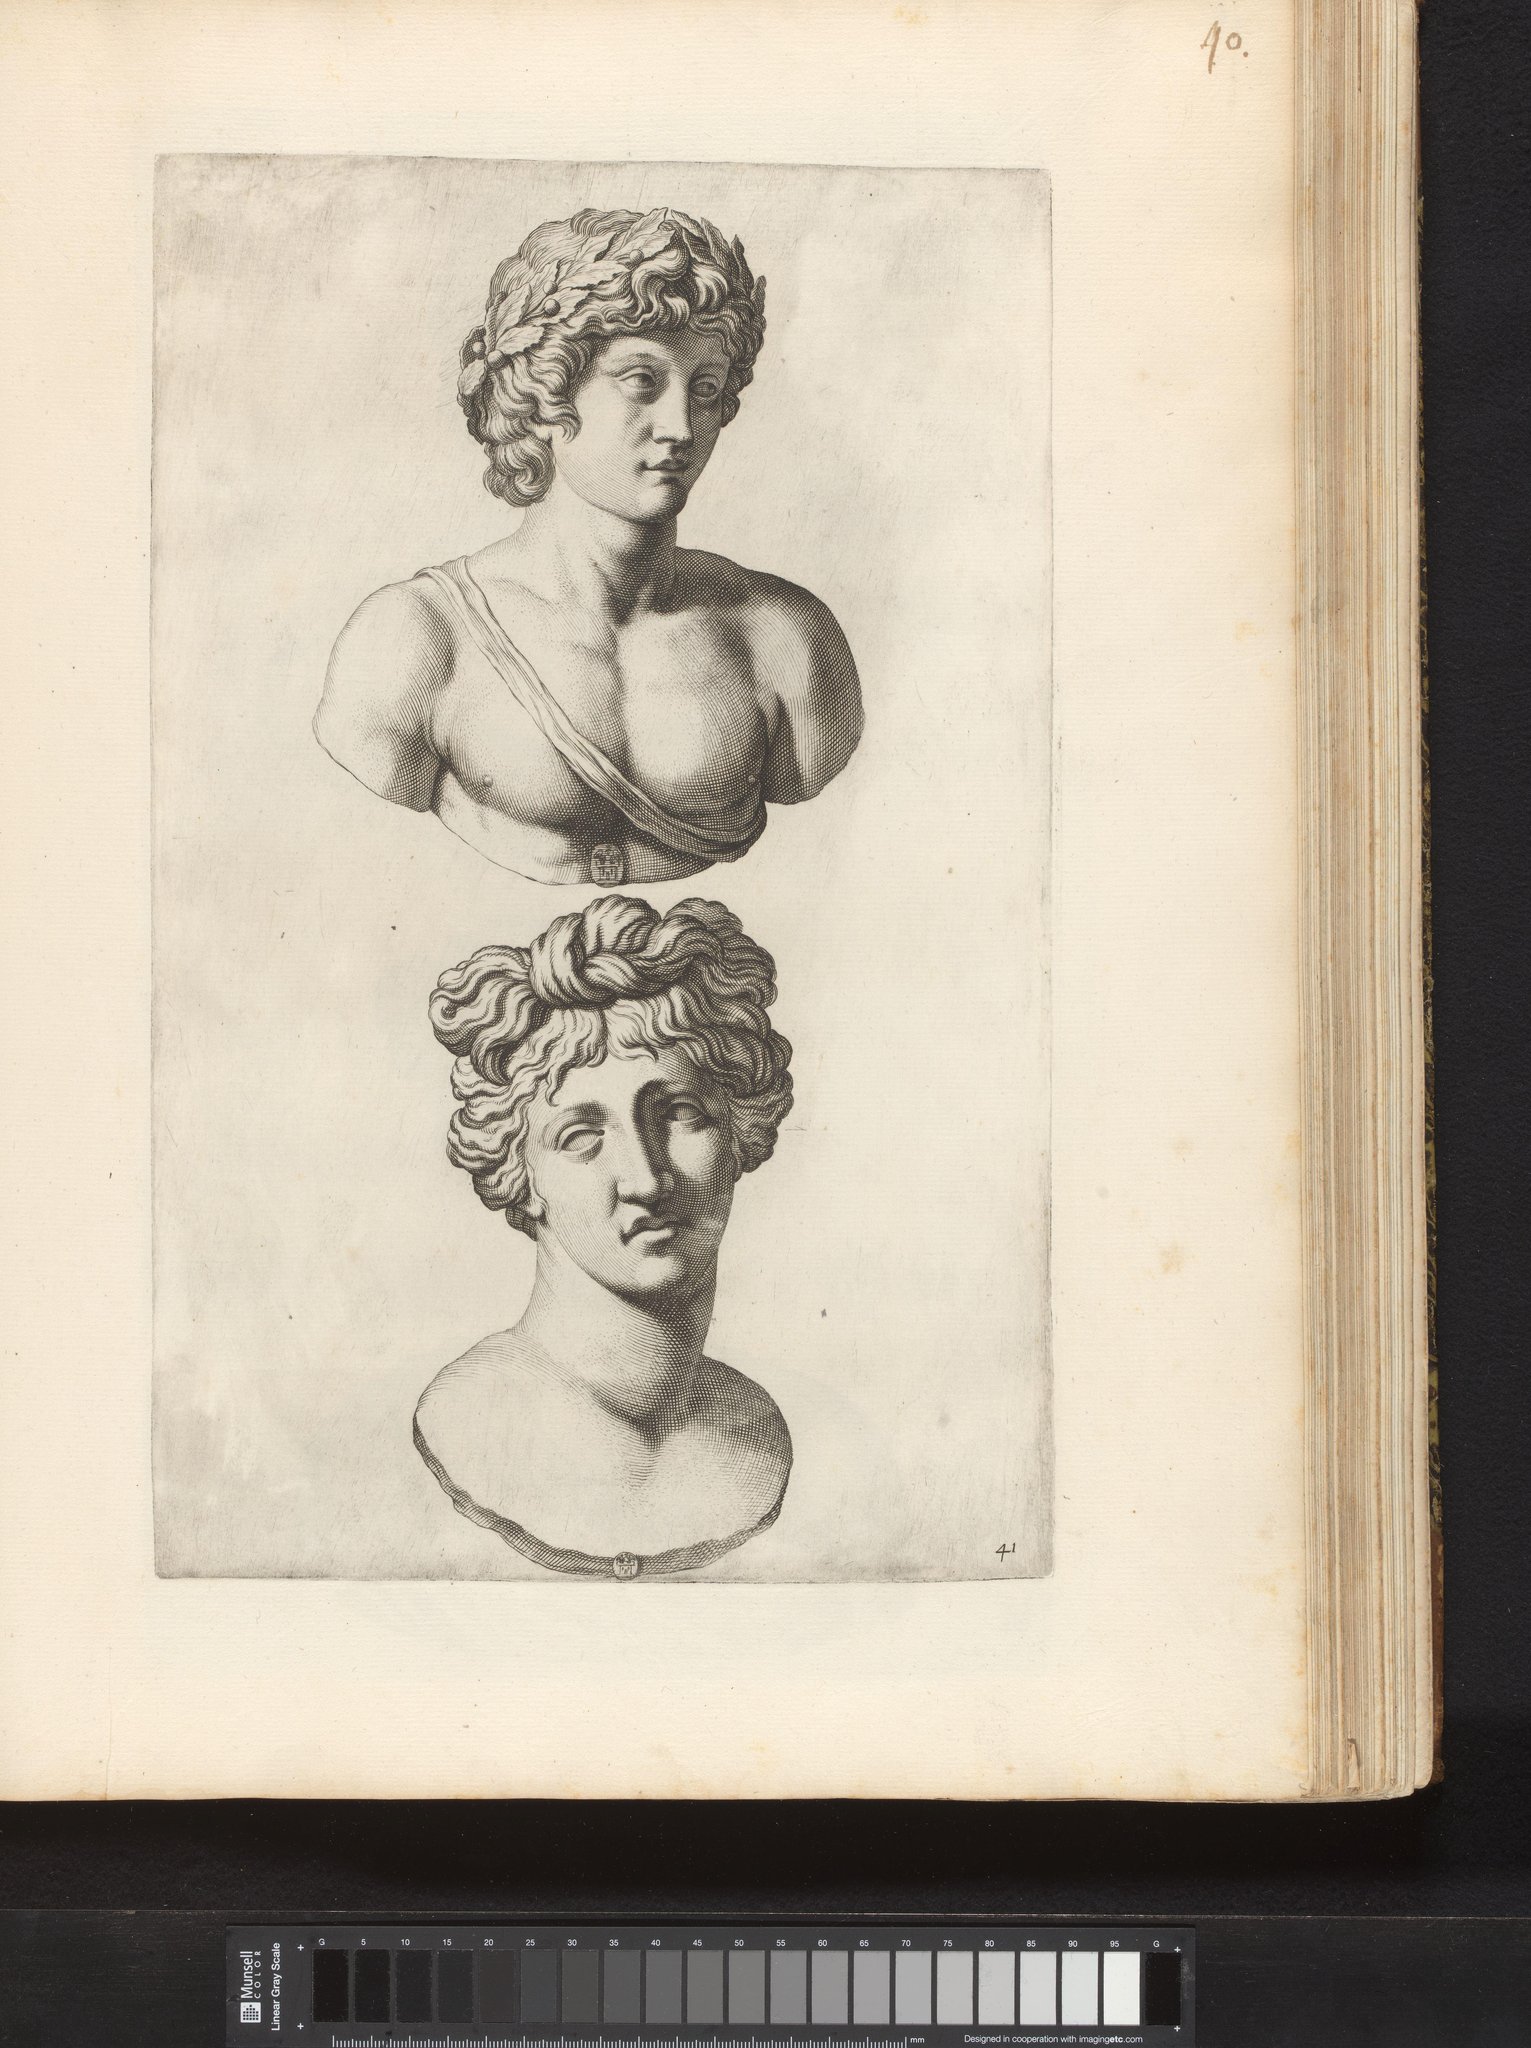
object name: print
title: Galleria Giustiniana del Marchese Vincenzo Giustiniani II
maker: michel natalis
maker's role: print maker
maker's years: 1610-1668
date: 1636-1647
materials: paper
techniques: engraving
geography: rome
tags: africa represented allegorically; 'africa' (ripa), (story of) jupiter (zeus), piece of sculpture, reproduction of a piece of sculpture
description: Twee zuilen met gezichten. Boven mogelijk het gezicht van Jupiter. Onder de personificatie van Afrika met de slurf en slagtanden van een olifant op haar hoofd. Op de bustes het wapenschild van Vincenzo Giustiniani. Prent maakt deel uit van een album met een serie prenten naar de sculpturen in de verzameling in de Galleria Giustiniani te Rome.